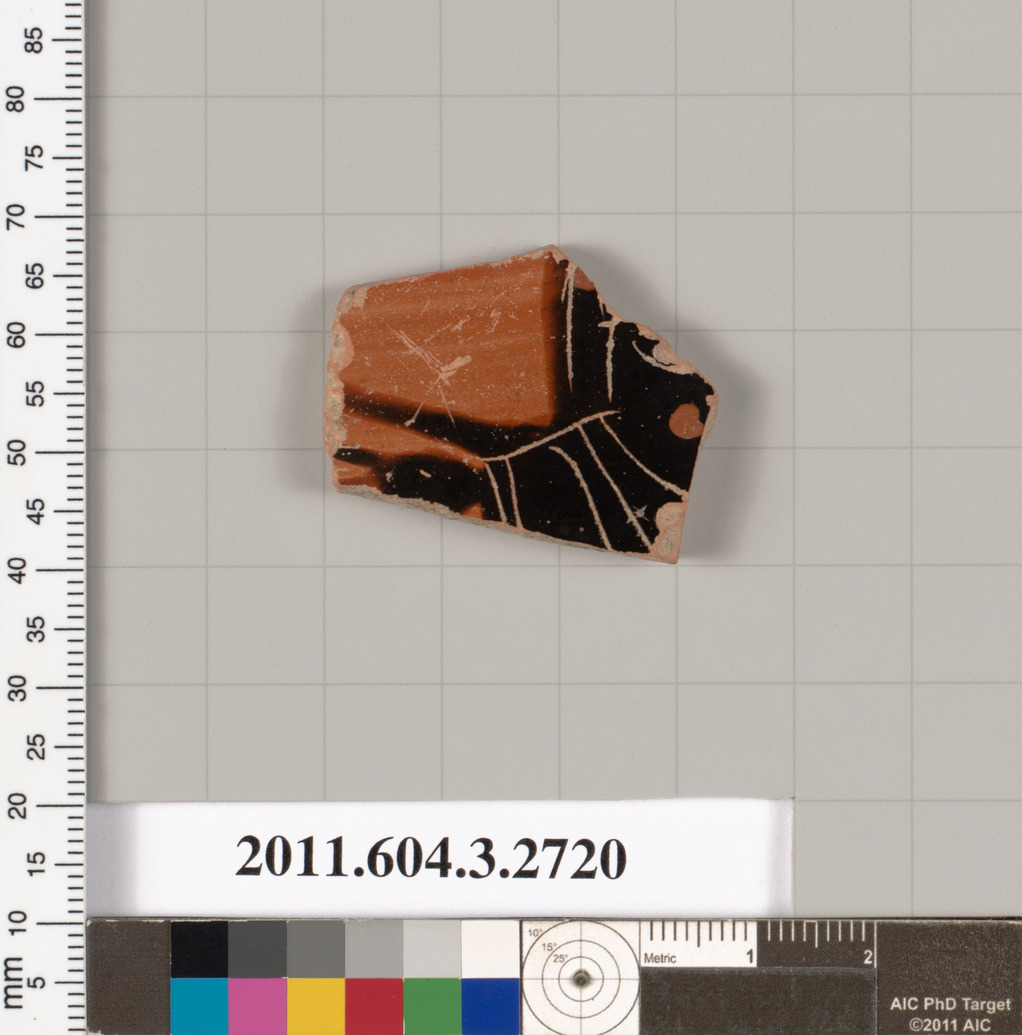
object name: oinochoe or olpe fragment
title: Terracotta fragment of an oinochoe (jug) or olpe (jug)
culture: greek, attic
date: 534-468 BCE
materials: terracotta